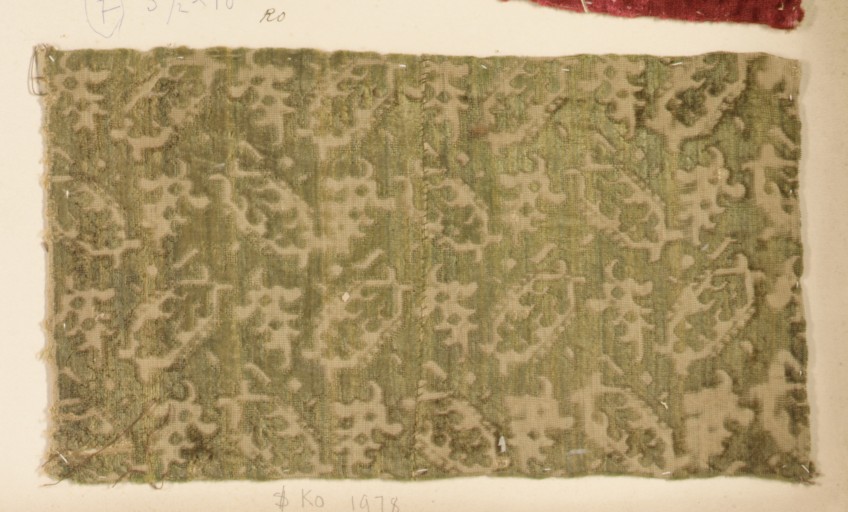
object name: fragment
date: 1501-1600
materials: silk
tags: leaves